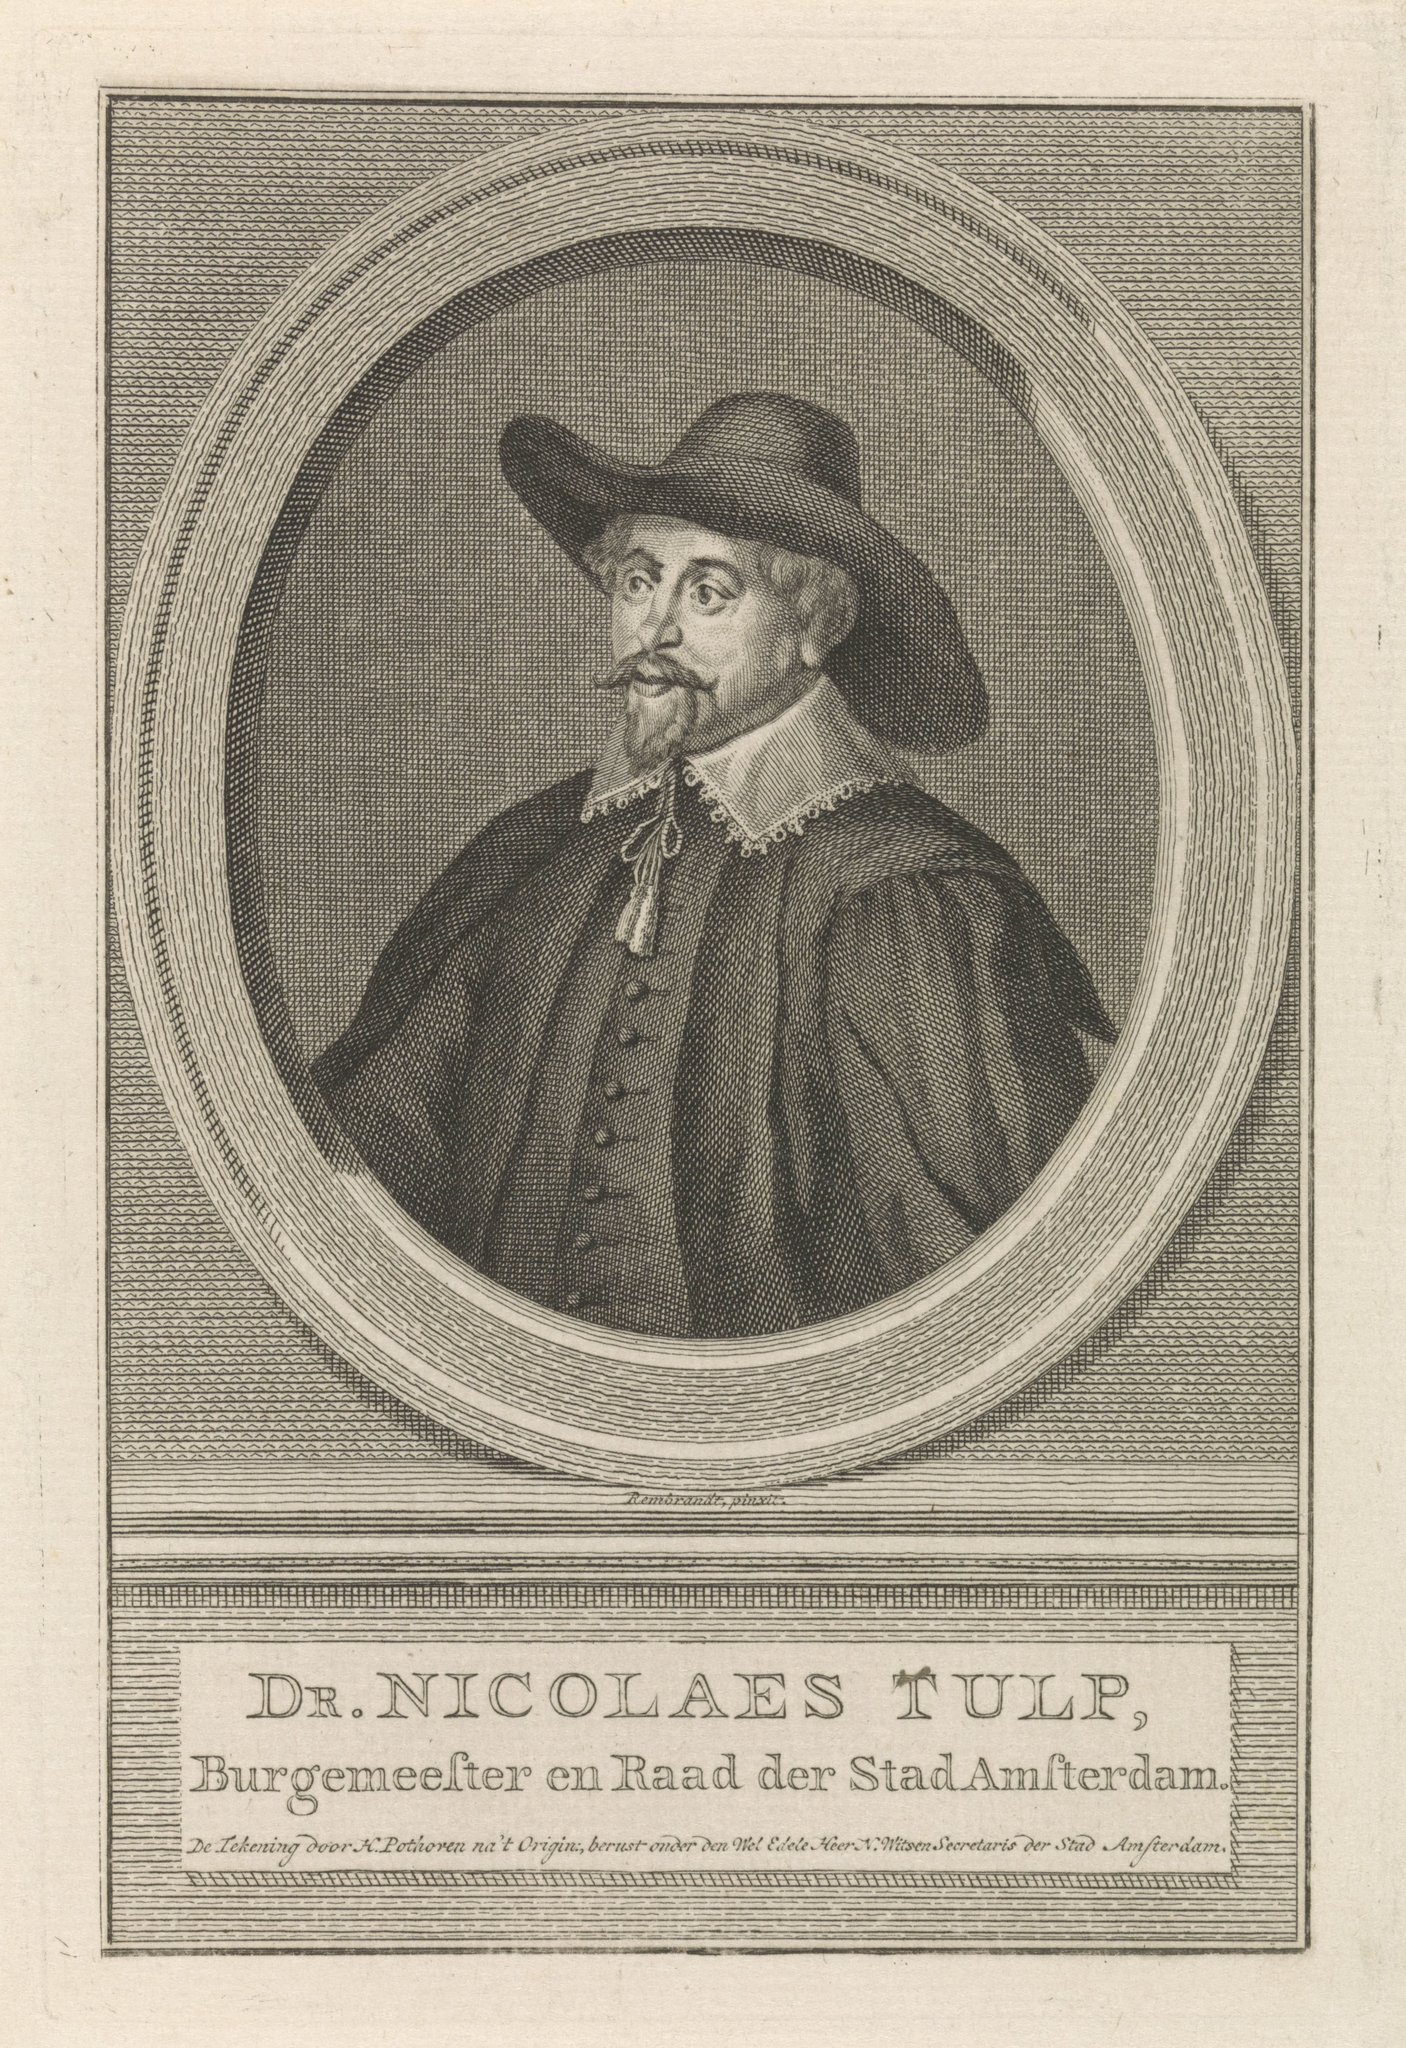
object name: print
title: Dr. Nicolaes Tulp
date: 1780-1830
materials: paper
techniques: engraving, etching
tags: amsterdam, the hague, mayor, historical persons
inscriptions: collector's mark: Lugt 2228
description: Kopie van de prent bedoeld voor: Jan Wagenaar, Vaderlandsche historie, vervattende de geschiedenissen der nu Vereenigde Nederlanden, inzonderheid die van Holland (...), 21 delen. Amsterdam, Isaak Tirion, 1749-59.